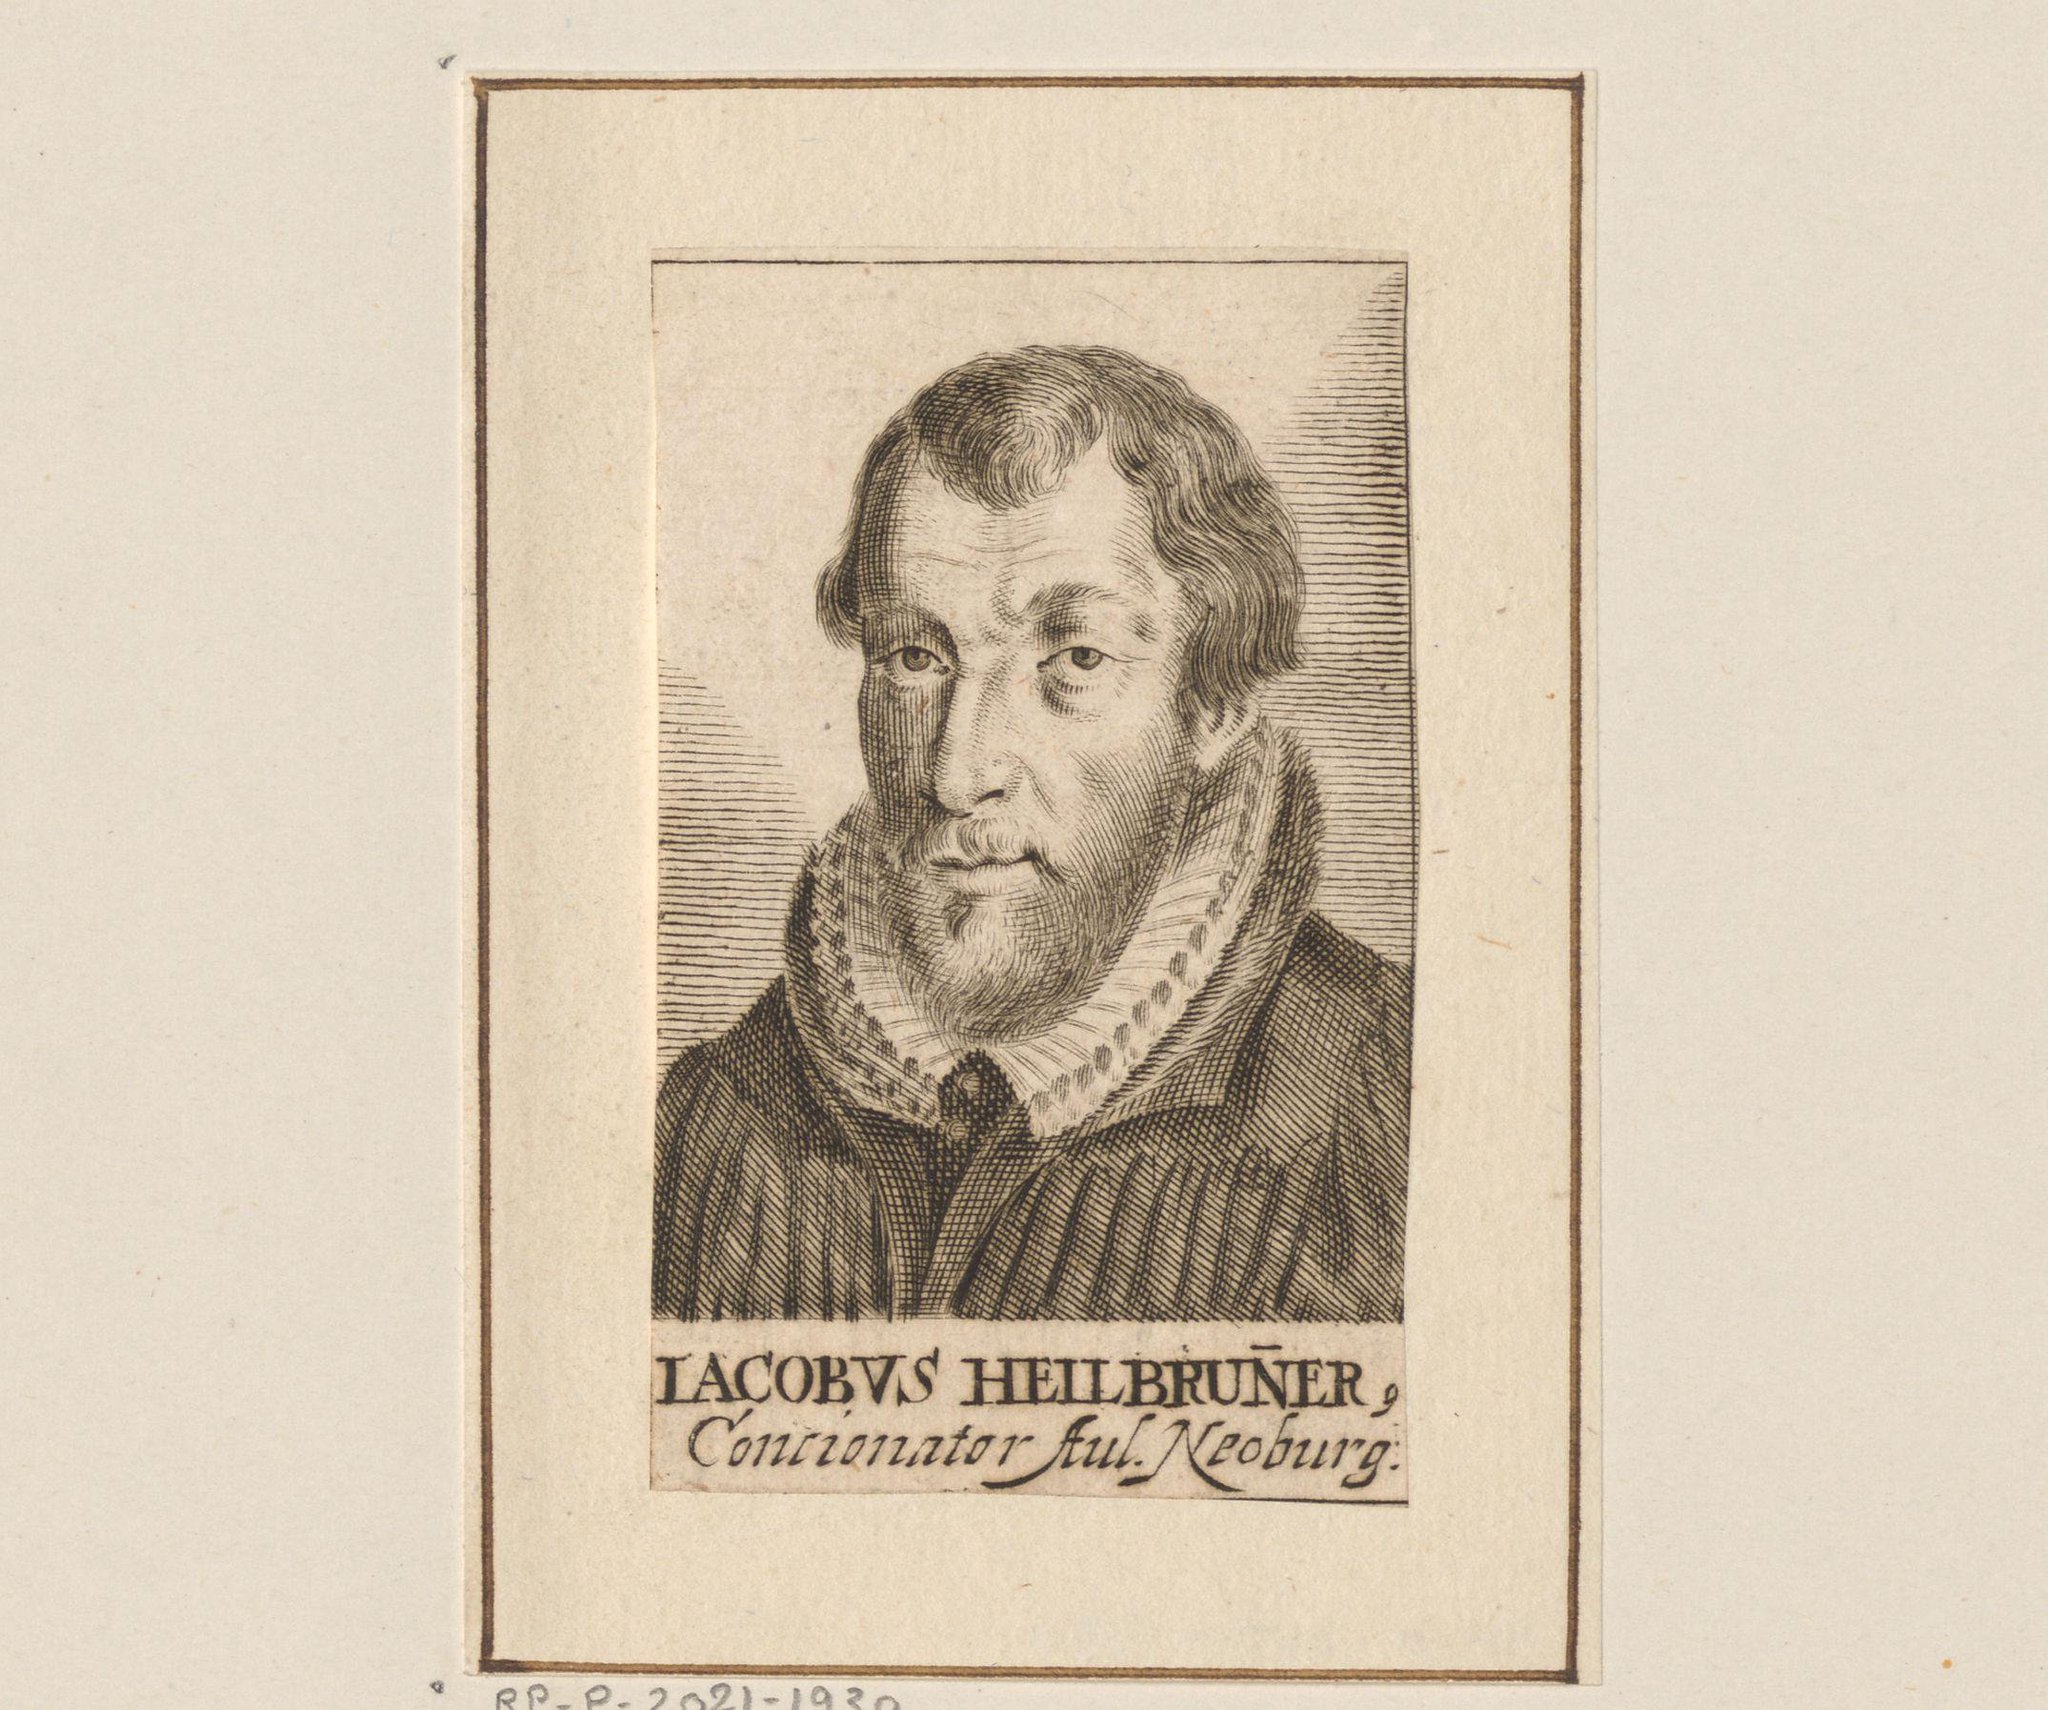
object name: book illustration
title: Portret van Jakob Heilbrunner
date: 1688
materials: paper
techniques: engraving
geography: nuremberg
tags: theologian, historical persons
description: Prent uit: Freher, Paul. Theatrum virorum eruditione clarorum. Neurenberg: Johann Hoffmann, 1688.